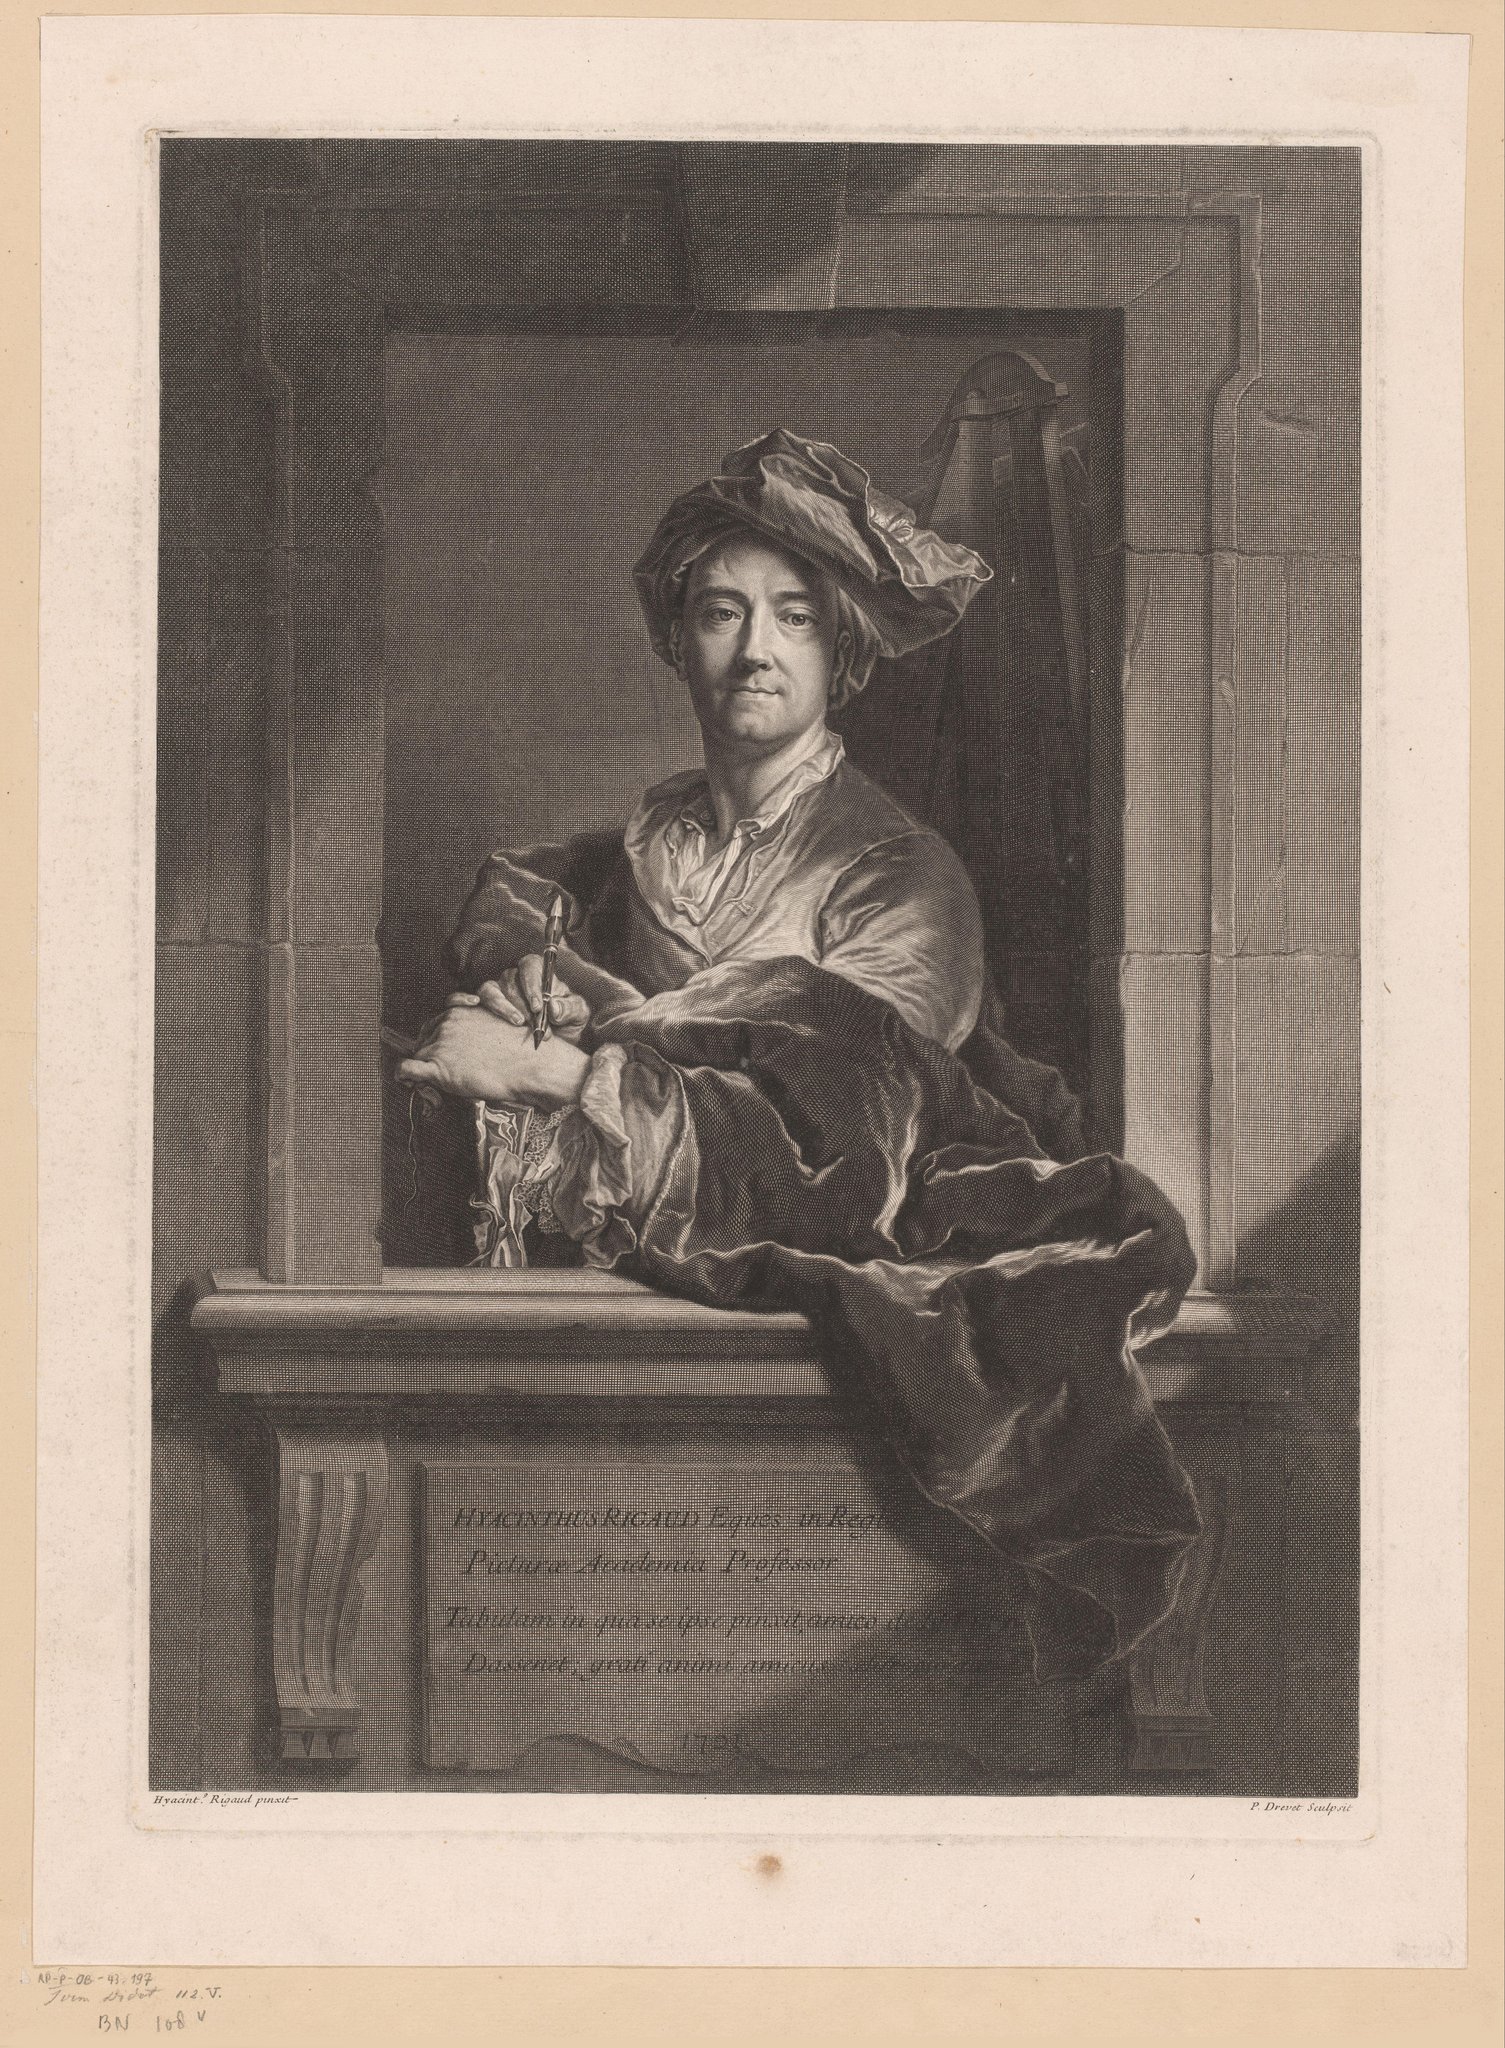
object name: print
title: Hyacinthus Rigaud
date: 1701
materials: paper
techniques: engraving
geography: france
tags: paris, painter, draughtsman, hyacinthe rigaud, portrait, self-portrait of painter, human figure at (open) window, seen from outside - aa - feigned window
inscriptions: collector's mark: Lugt 240